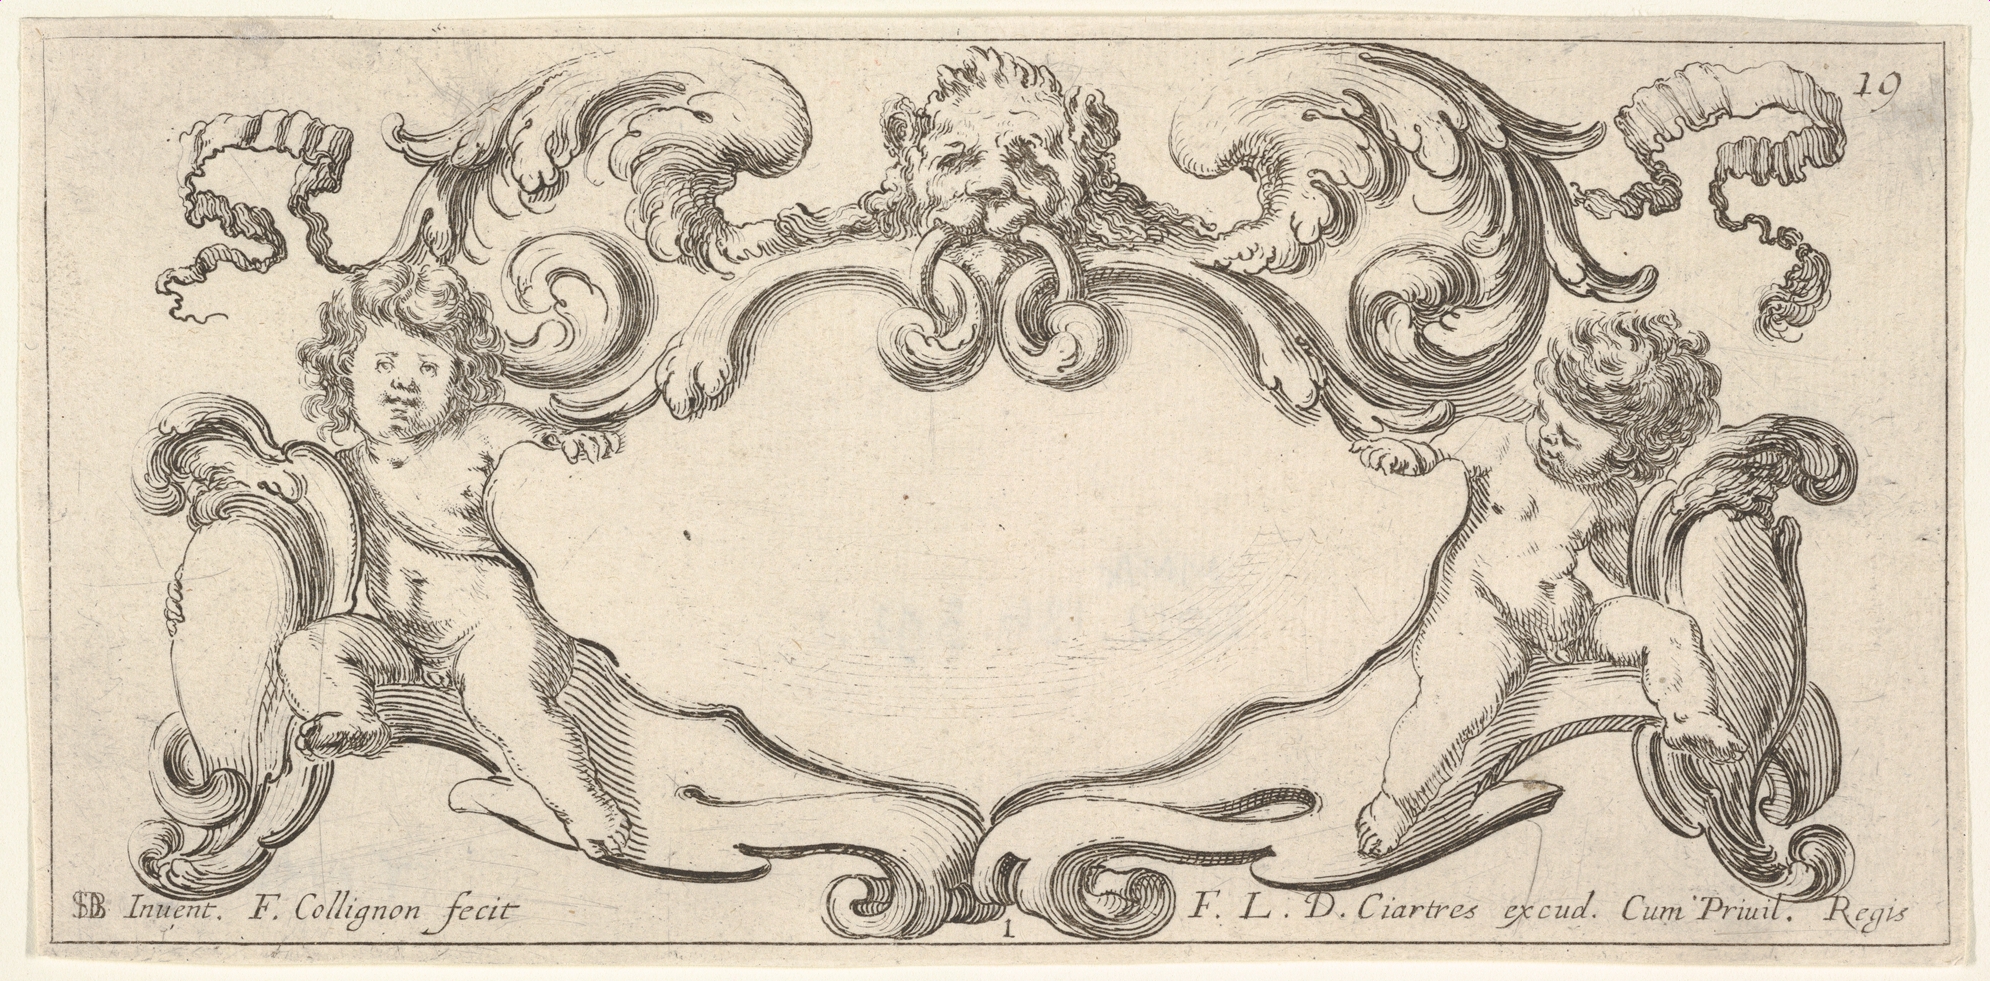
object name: print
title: Plate 1: a cartouche with a lion head with wings at top center, a putto holding a blank escutcheon to either side, from "Twelve cartouches" (Recueil de douze cartouches)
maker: françois collignon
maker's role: artist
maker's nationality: french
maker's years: 1605-1687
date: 1640-1645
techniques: etching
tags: cartouches,putti